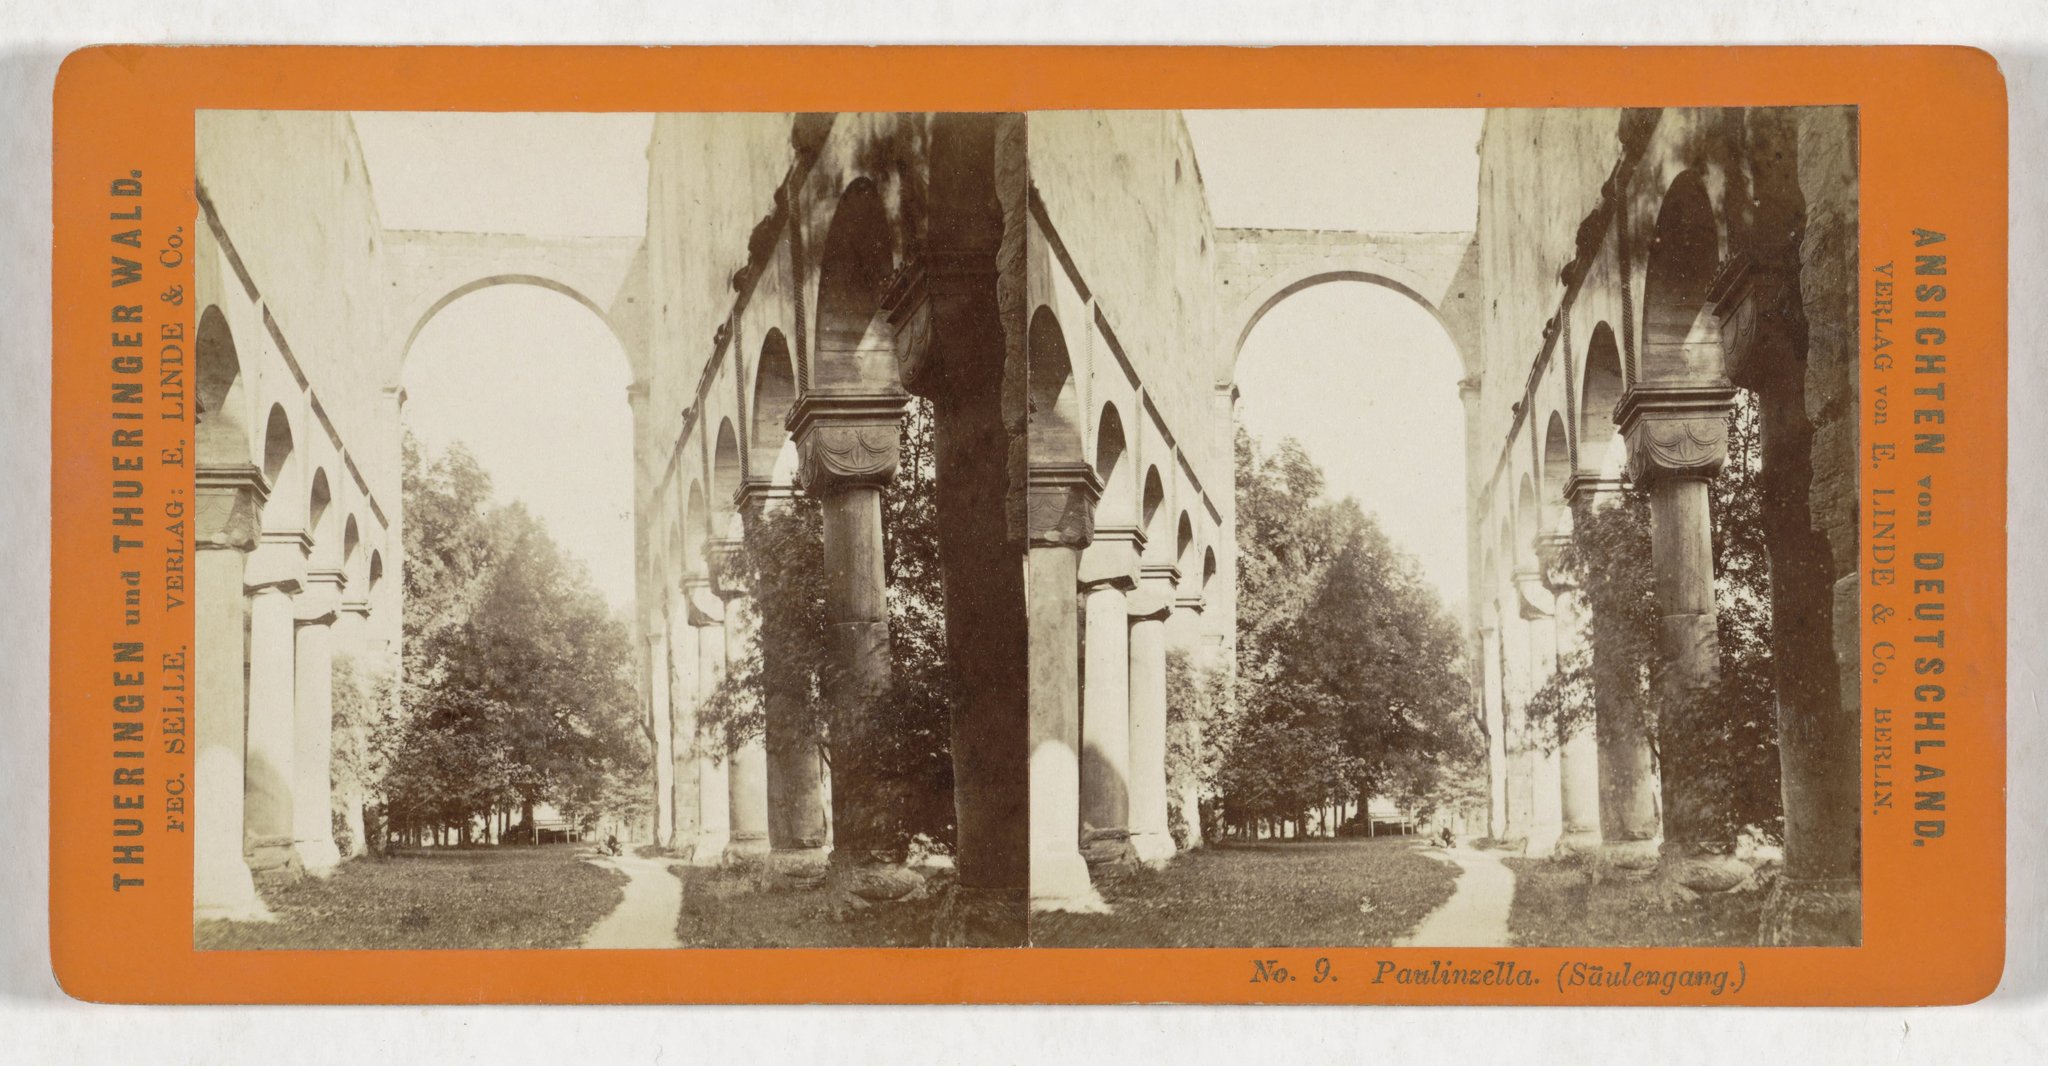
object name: stereograph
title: Paulinzella. (Säulengang)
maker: hermann selle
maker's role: fotograaf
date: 1868-1890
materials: cardboard, paper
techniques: albumen print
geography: berlin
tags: ruin of church, monastery, etc.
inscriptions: number: ‘No. 9.’